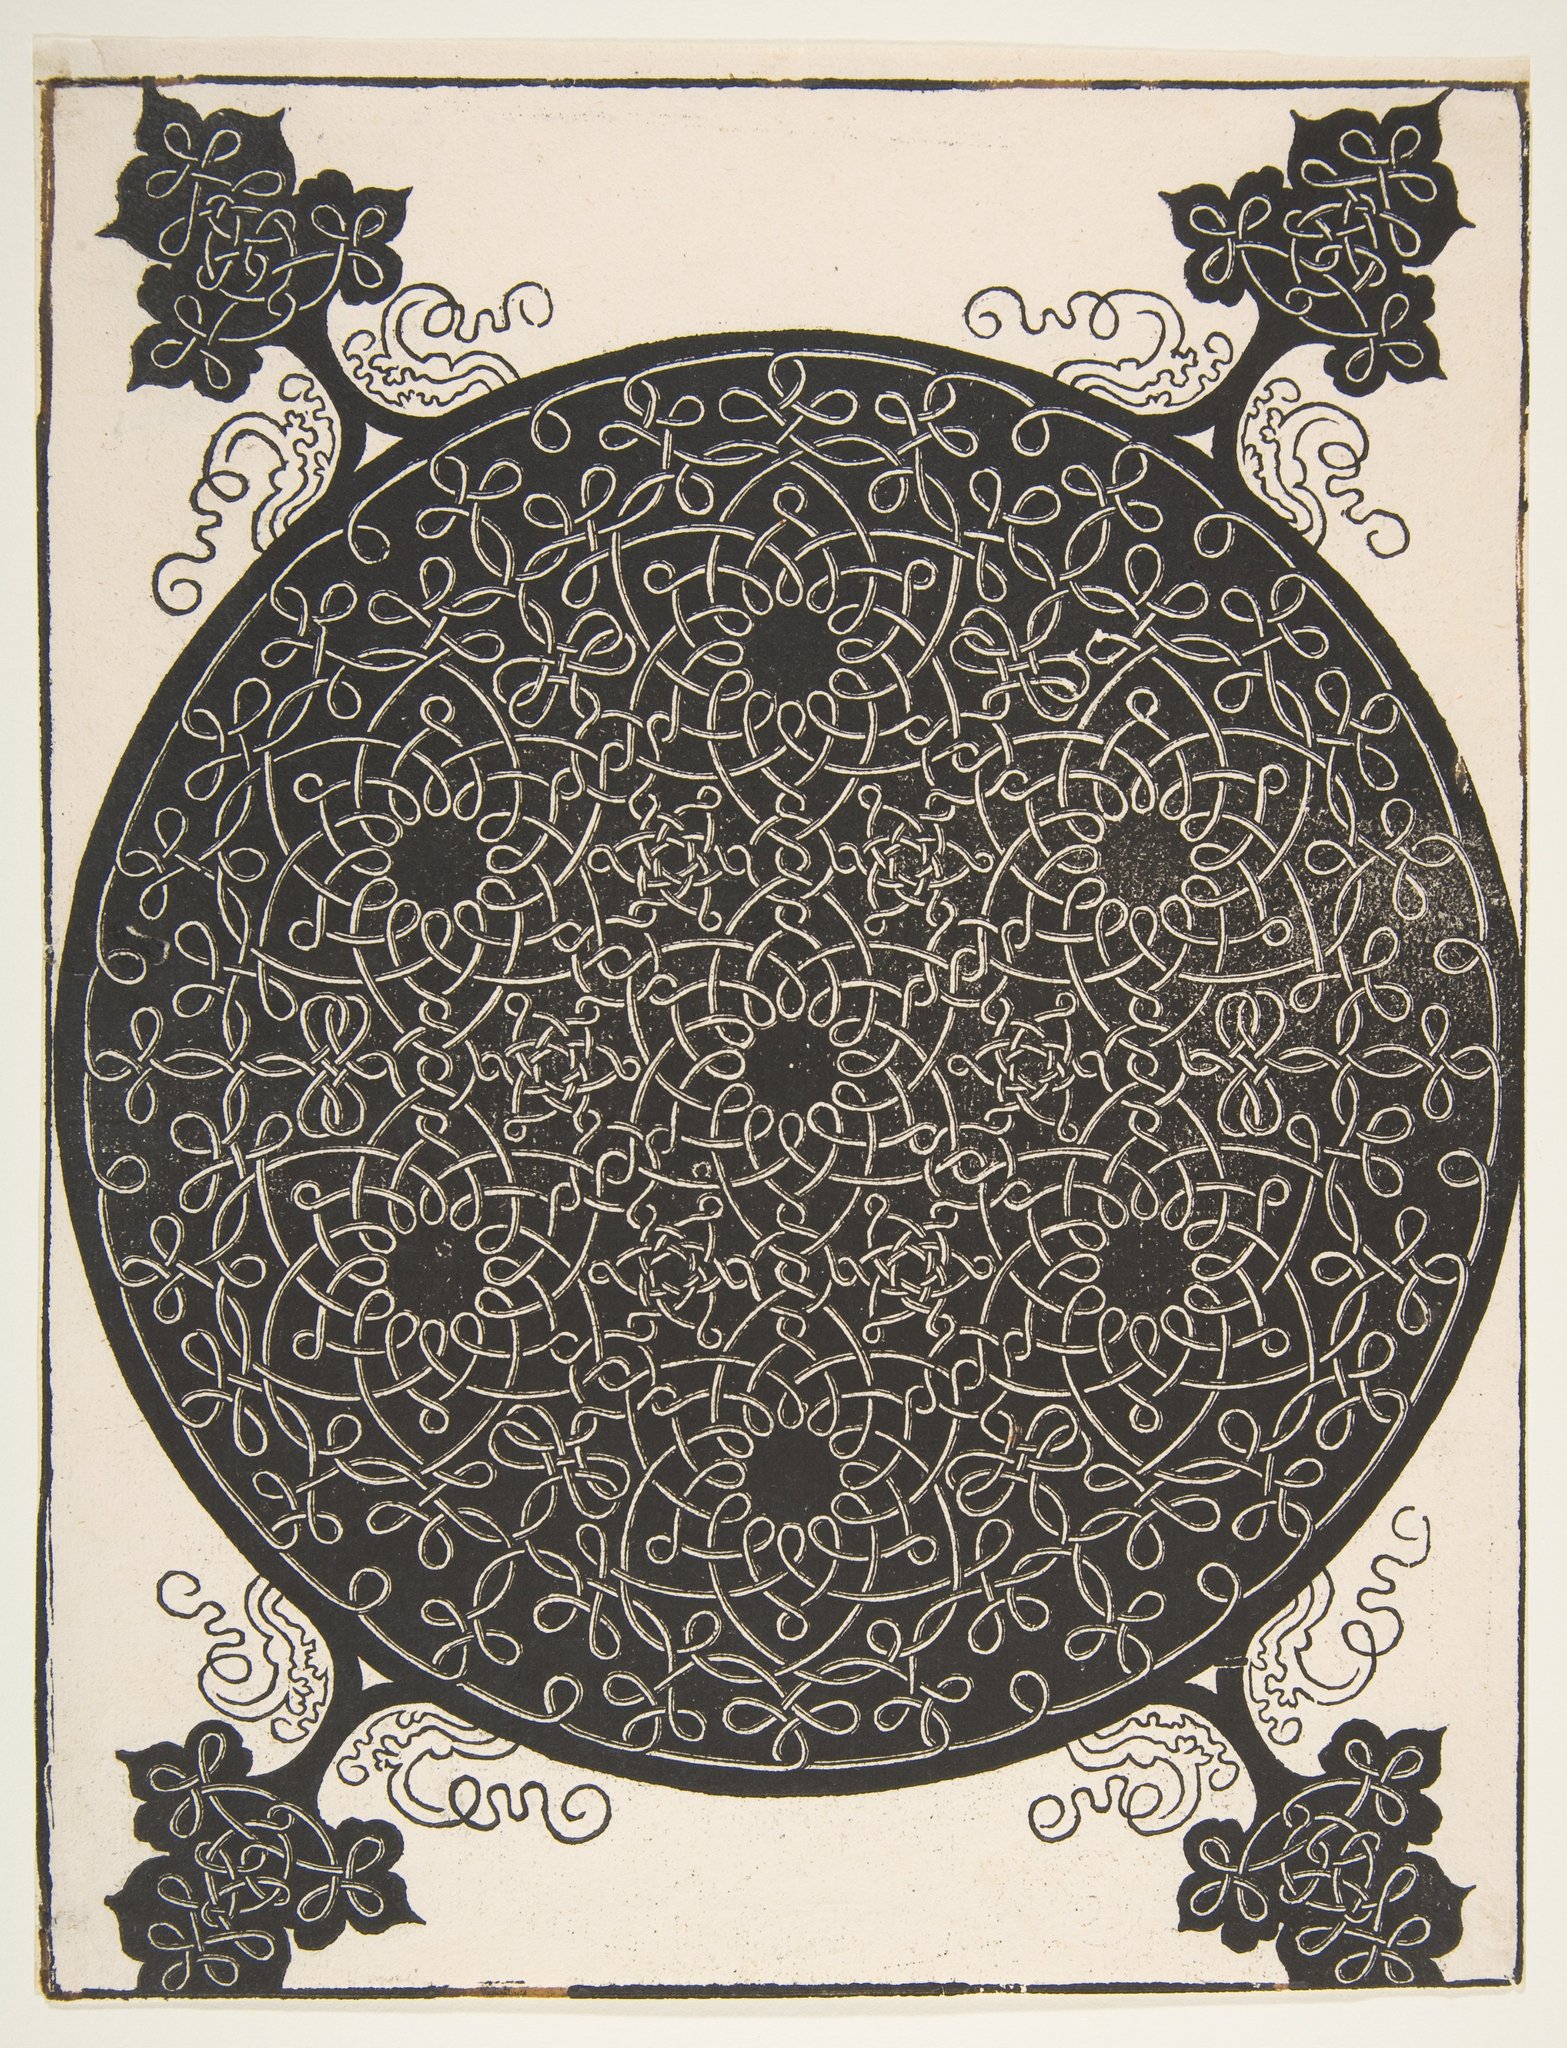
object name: collection ornament architecture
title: “The Fifth Knot”. Interlaced Roundel with Seven Six-pointed Stars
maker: albrecht dürer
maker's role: artist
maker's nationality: german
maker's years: 1471-1528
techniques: woodcut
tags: ornament